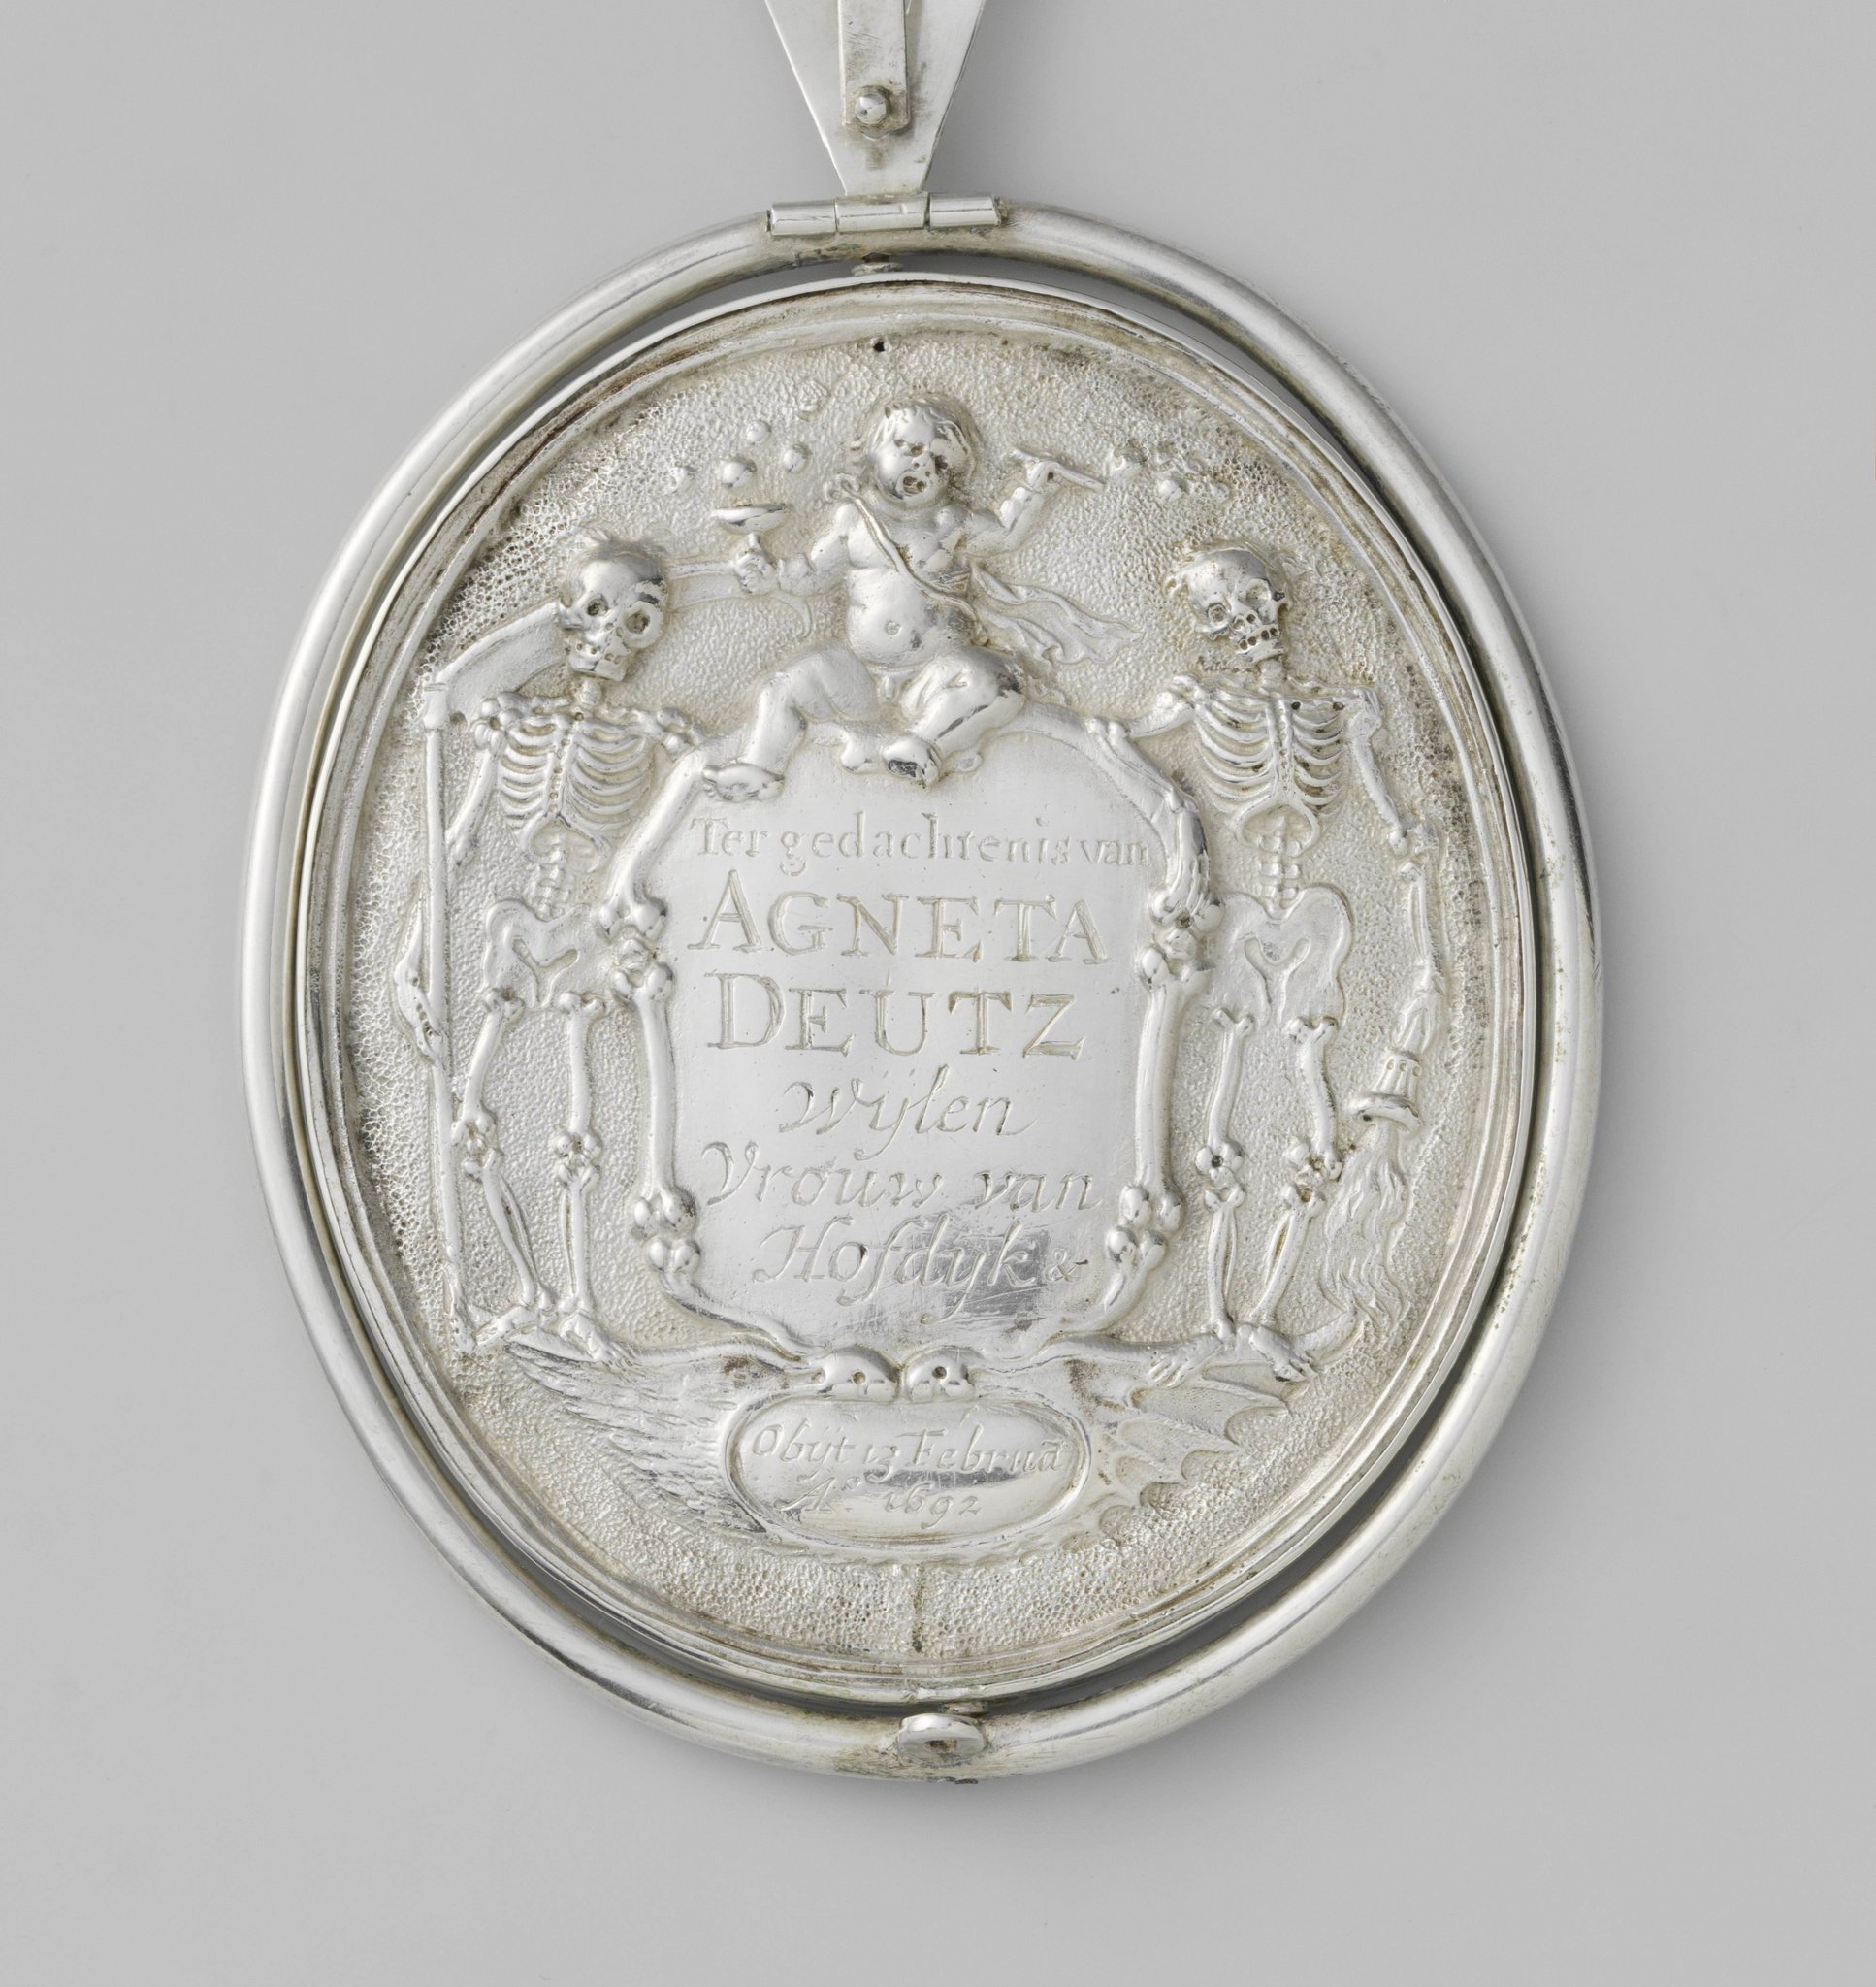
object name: family medal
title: Death of Agneta Deutz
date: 1692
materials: silver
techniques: engraving, screwed, soldering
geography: netherlands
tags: vrouwe van hofdijk deutz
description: In the past, important events were graced with a medal, especially in well-to-do families. The occasion for this was usually a birth, wedding, or death. These medals not only remained in the family as a memento, but were also given to the guests at the baptism, wedding party, or funeral. Sometimes they were purely private in character, such as the gold medal a grandfather gave to his grandson.